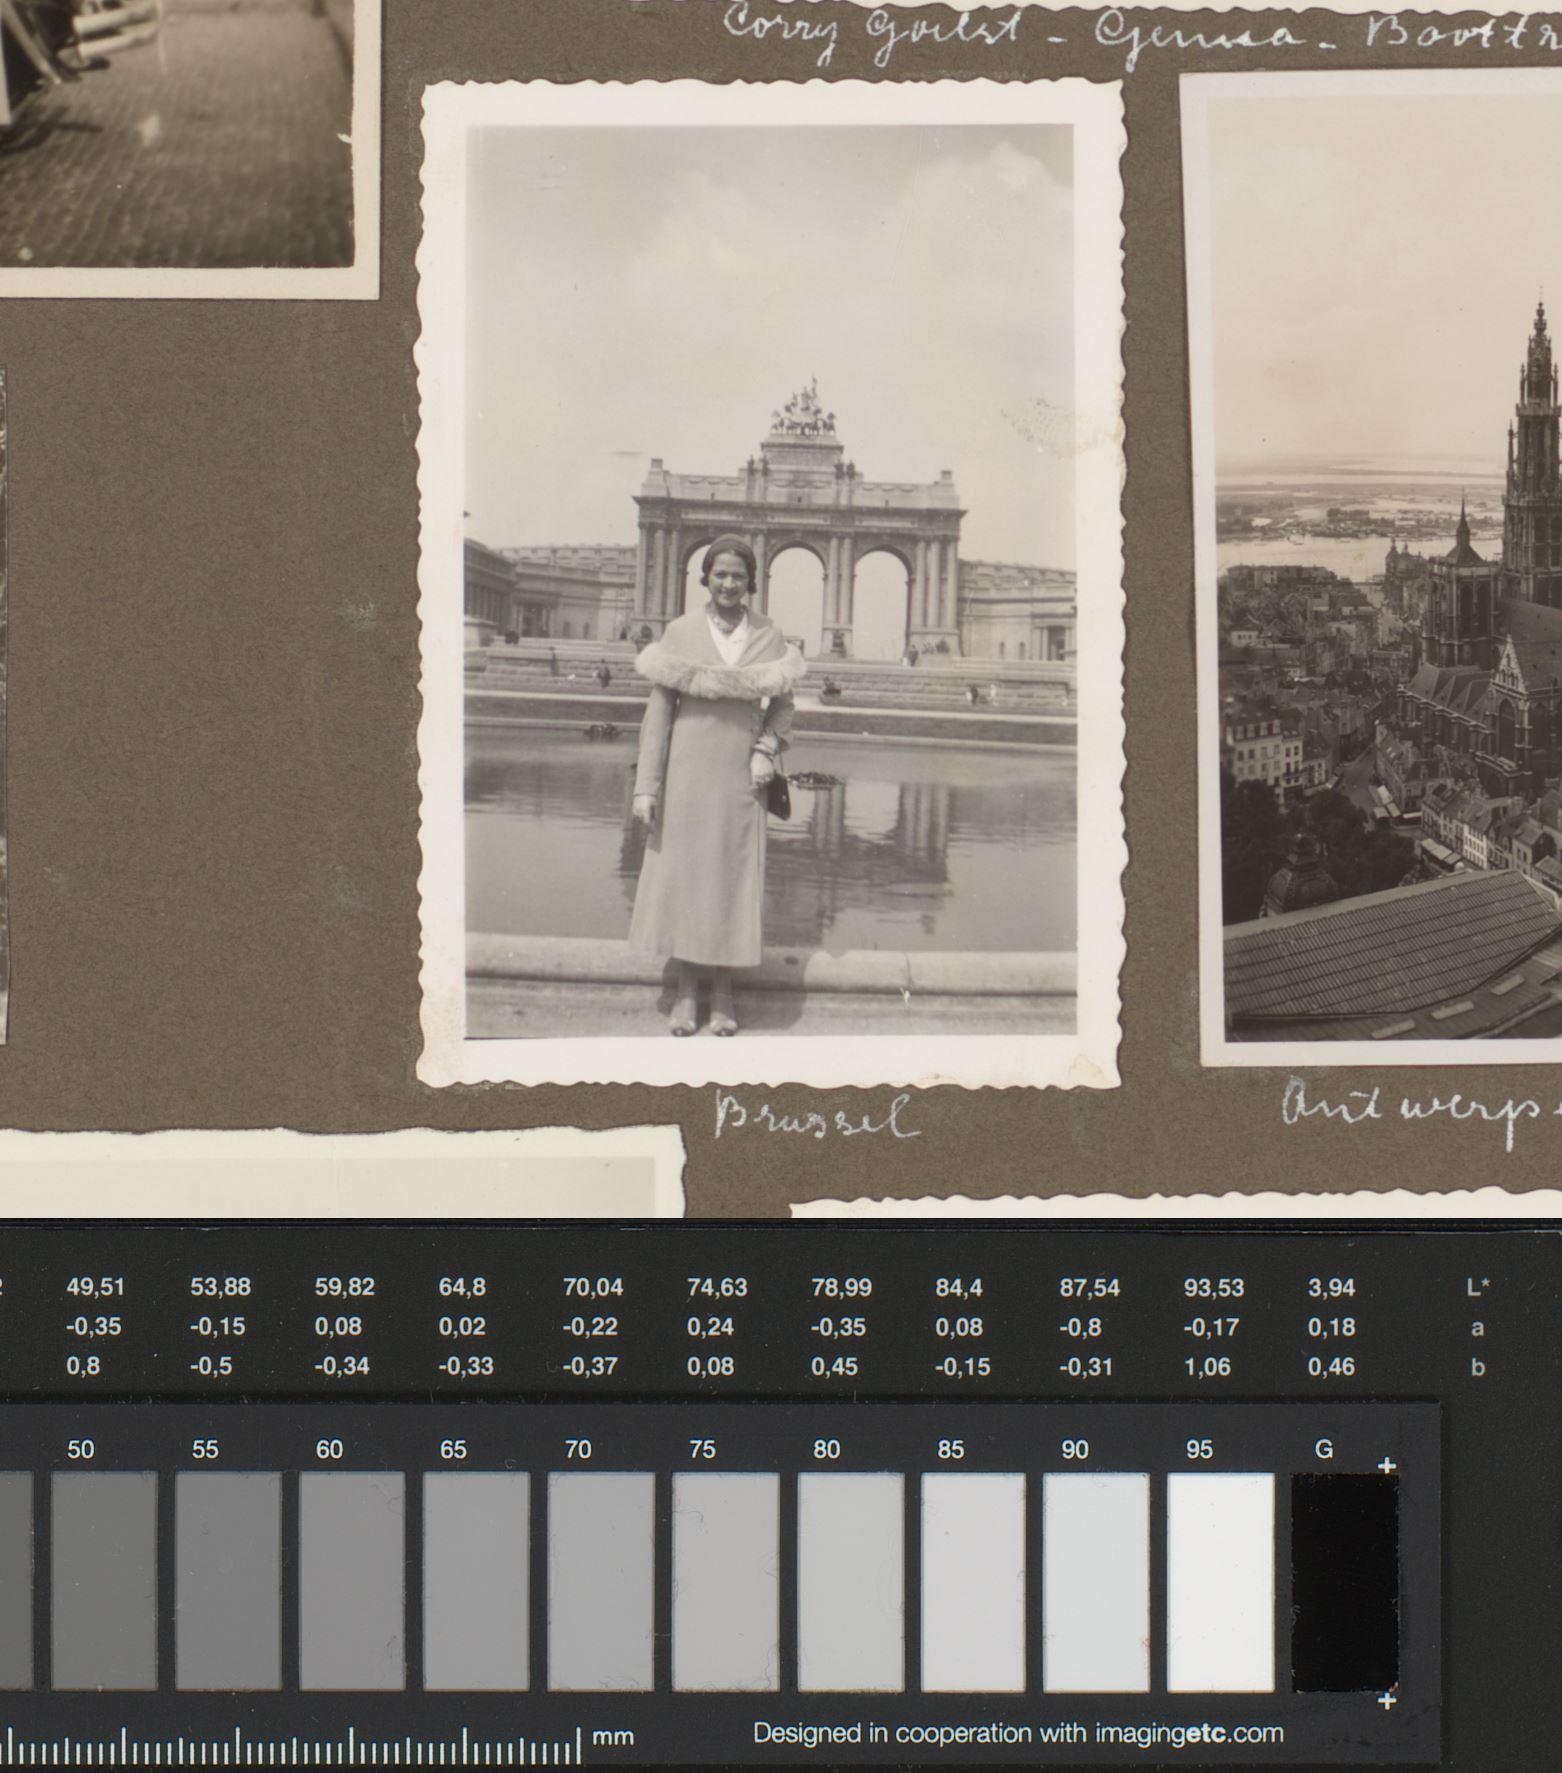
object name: photograph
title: Portret van Wilhelmina van Zijll de Jong in het Jubelpark, Brussel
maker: Anonymous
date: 1932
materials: paper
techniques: gelatin silver print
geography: brussels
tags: the hague, wilhelmina van zijll de jong, historical persons - bb - woman, triumphal arch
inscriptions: inscription: ‘Brussel’